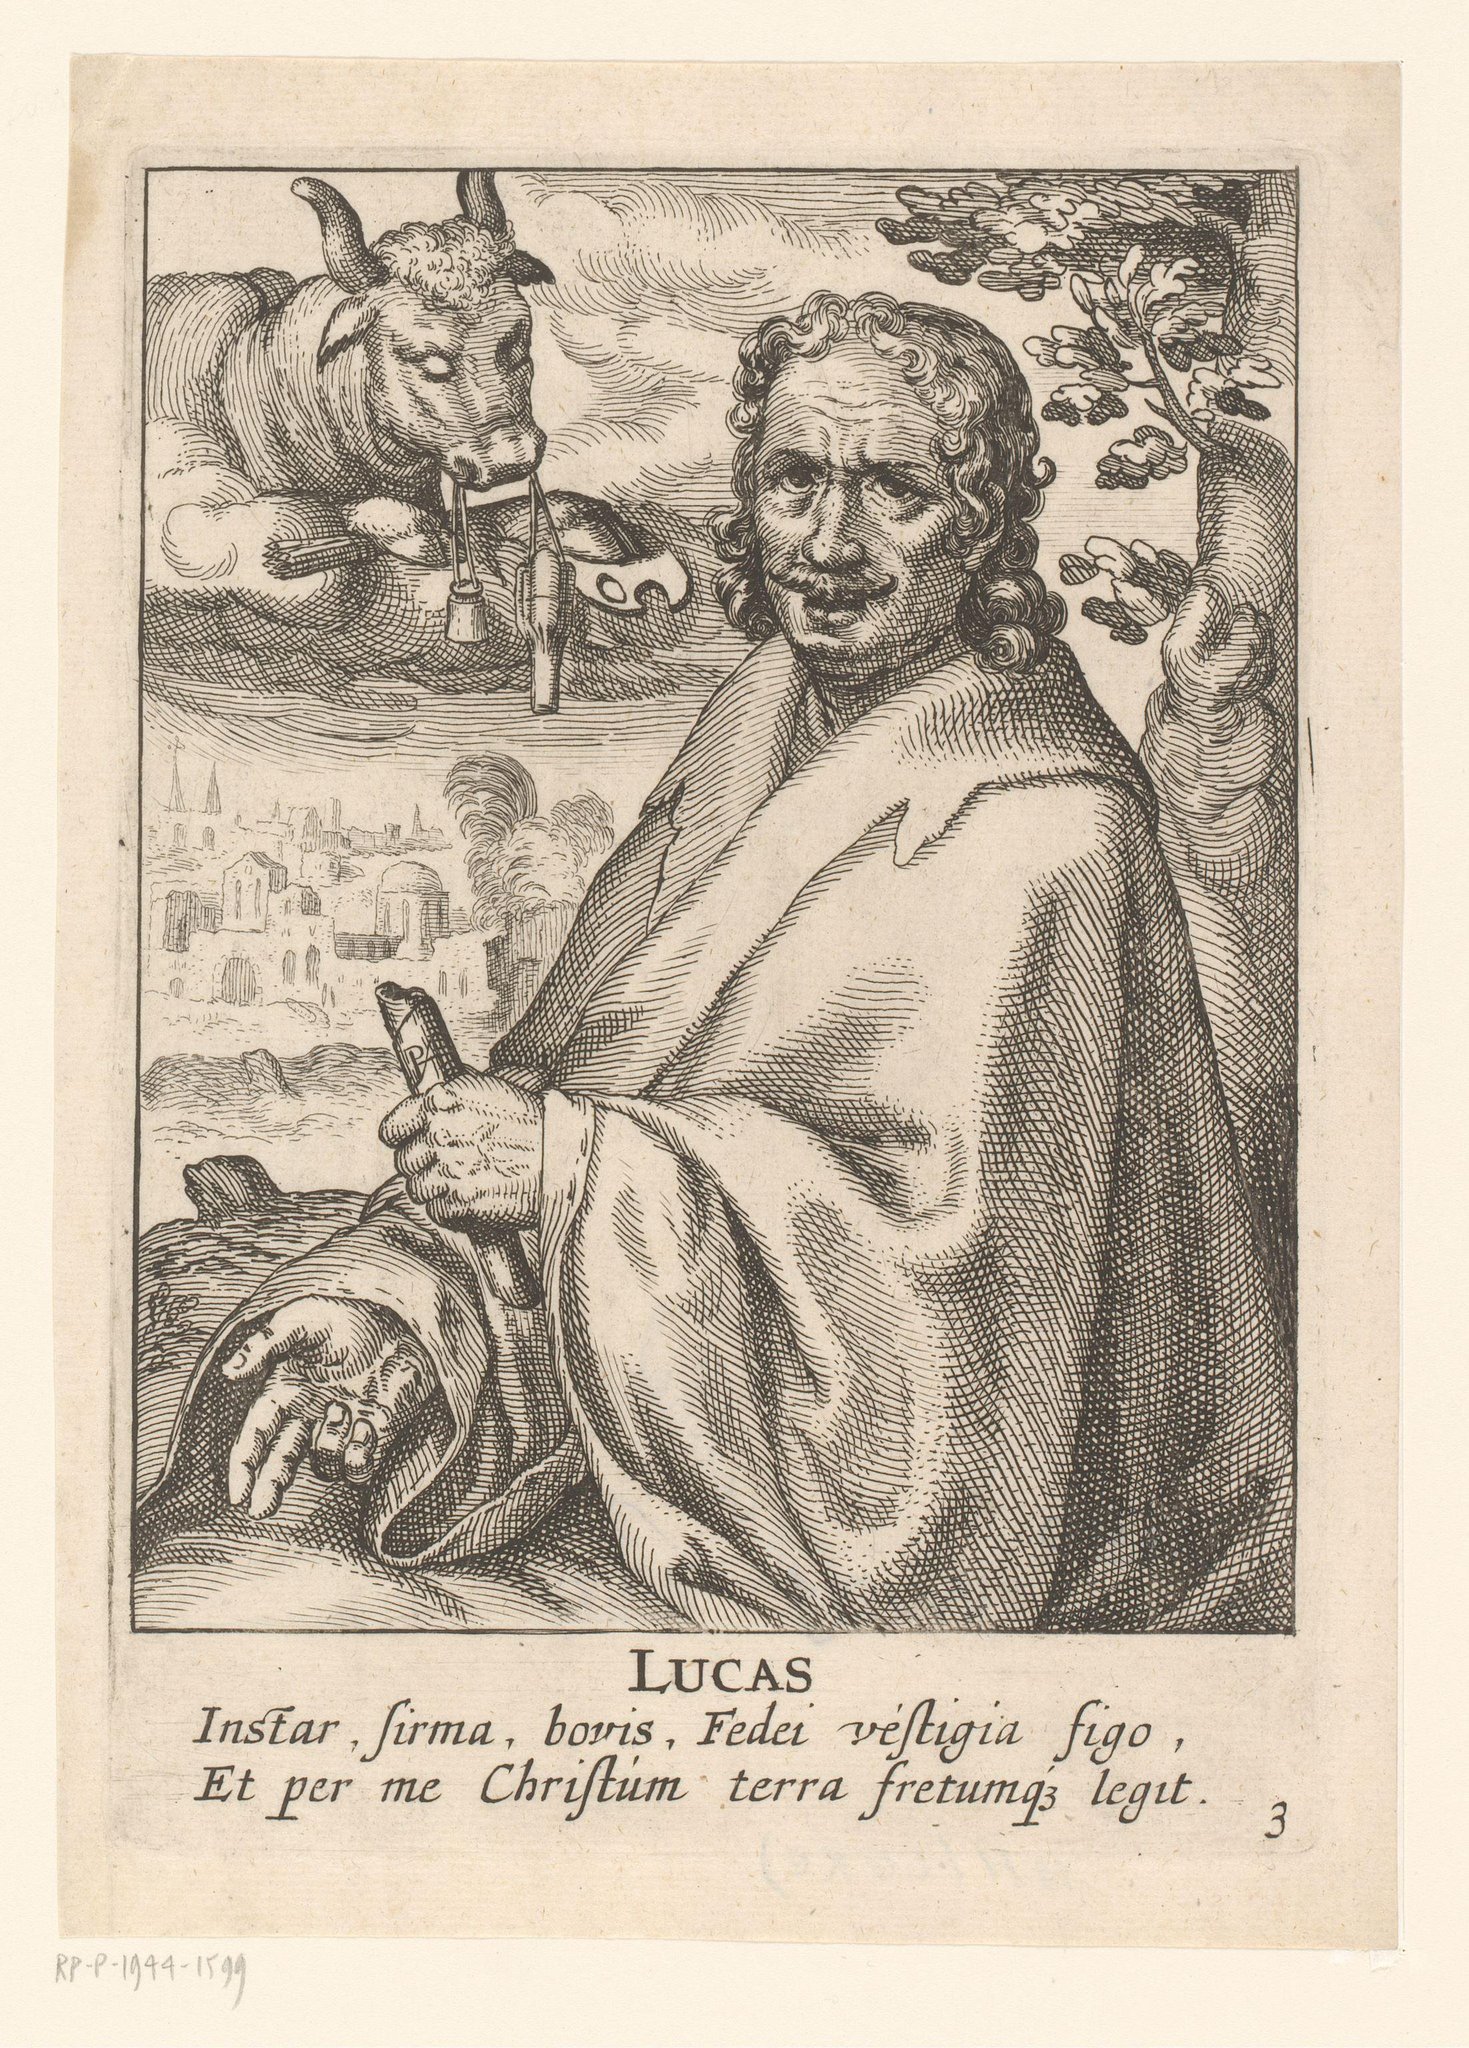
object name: print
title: Vier evangelisten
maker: pieter feddes van harlingen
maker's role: painter, print maker, publisher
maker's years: 1586-1623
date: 1596-1623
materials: paper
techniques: etching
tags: luke the evangelist; possible attributes: book, (winged) ox, portrait of the virgin, surgical instruments, painter's utensils, scroll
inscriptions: collector's mark: Lugt 2228